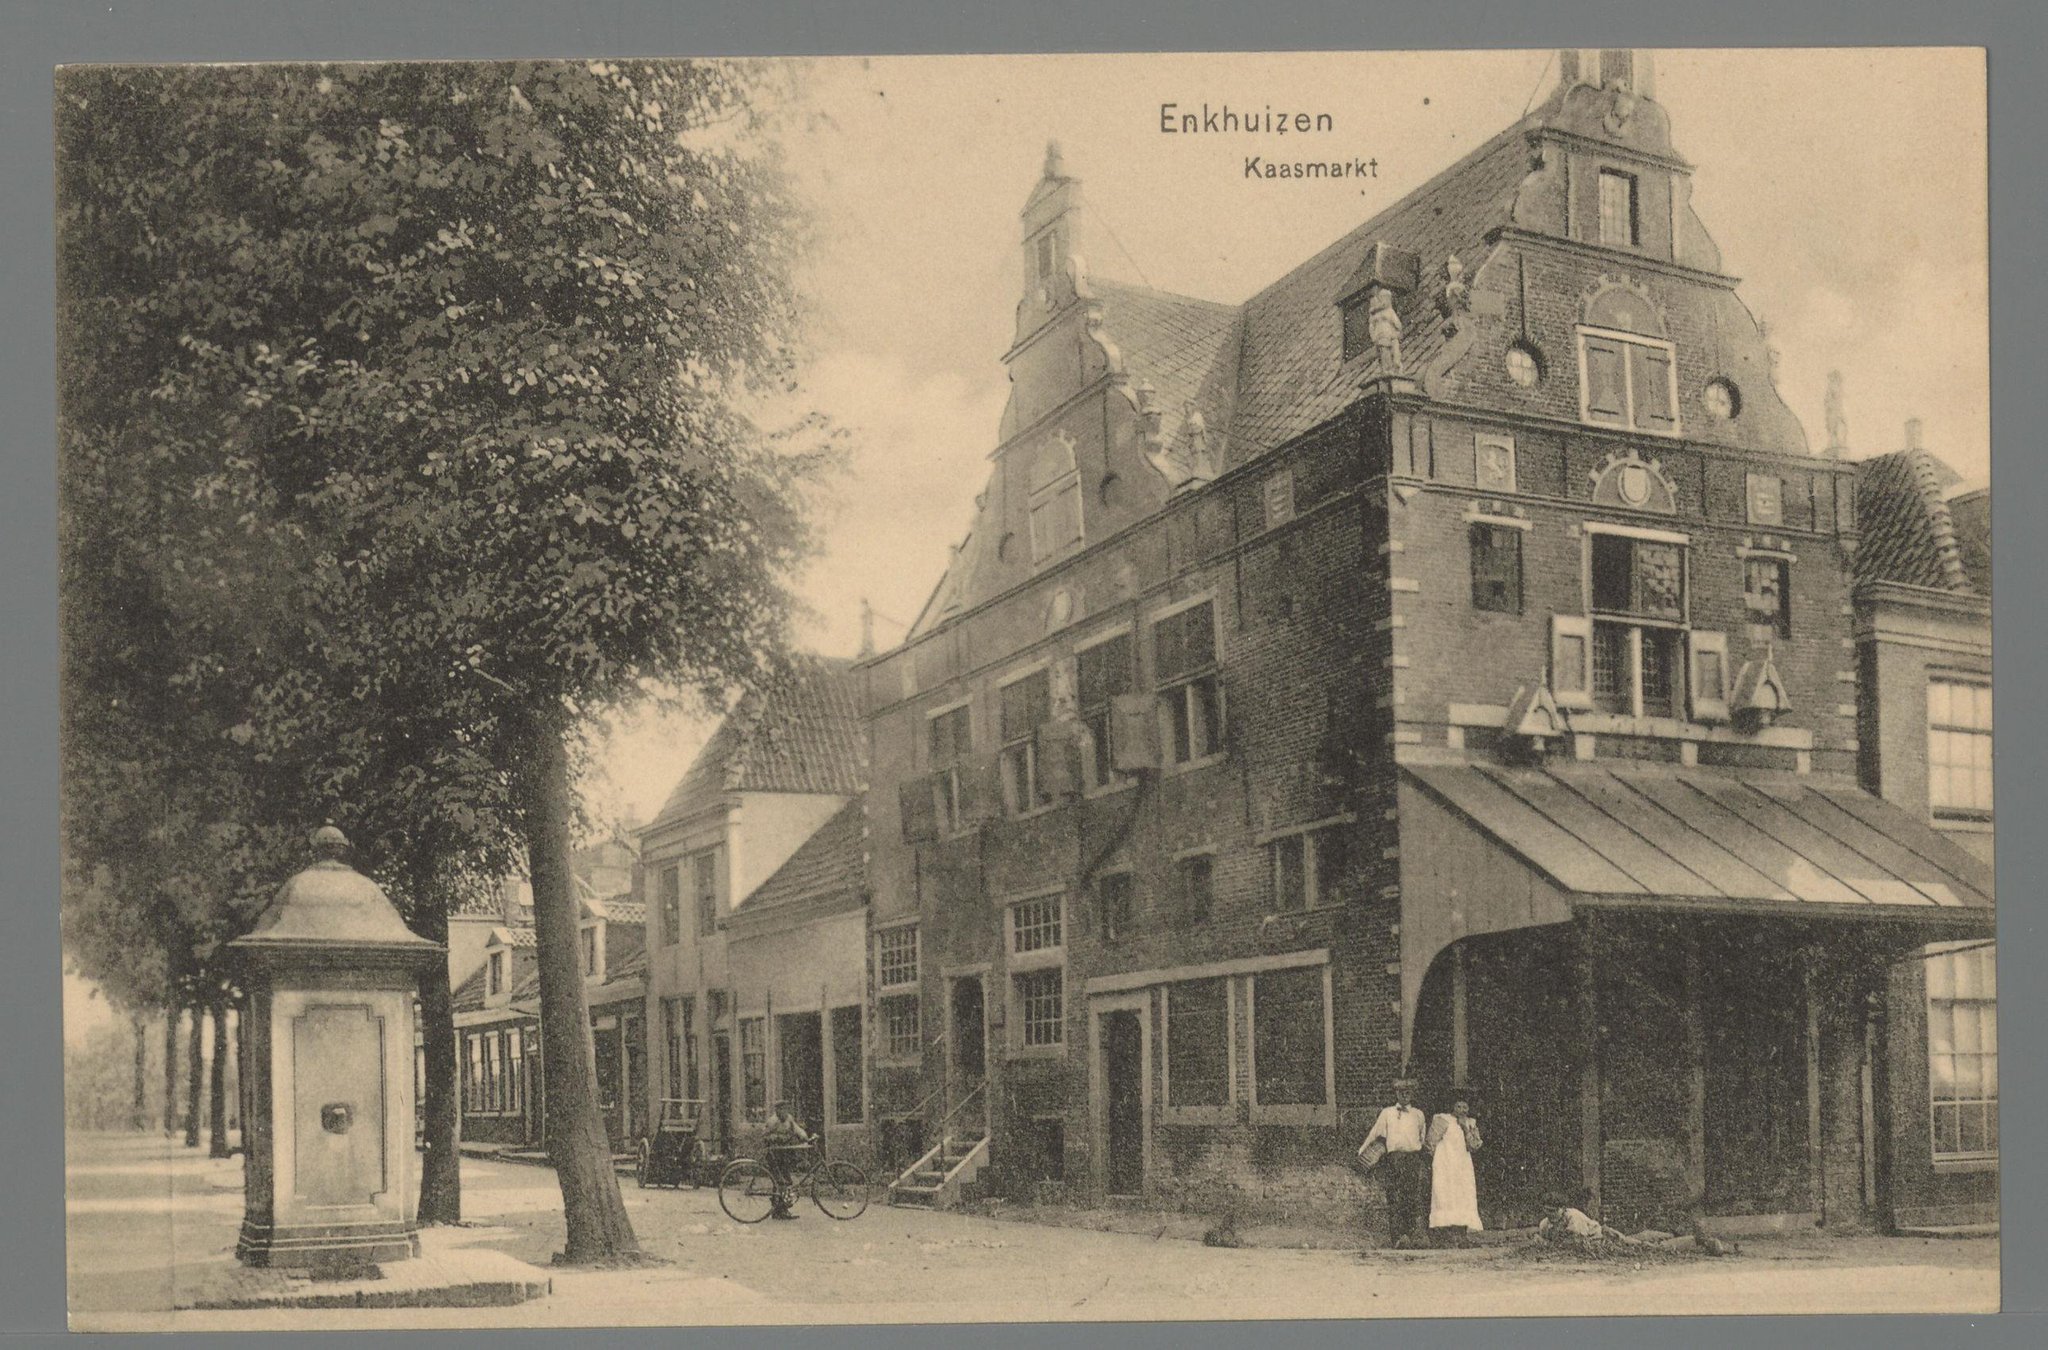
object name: photomechanical print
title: Enkhuizen. Kaasmarkt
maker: Anonymous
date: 1913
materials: cardboard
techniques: photograph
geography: the hague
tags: well, city-view, and landscape with man-made constructions, street, enkhuizen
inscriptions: date